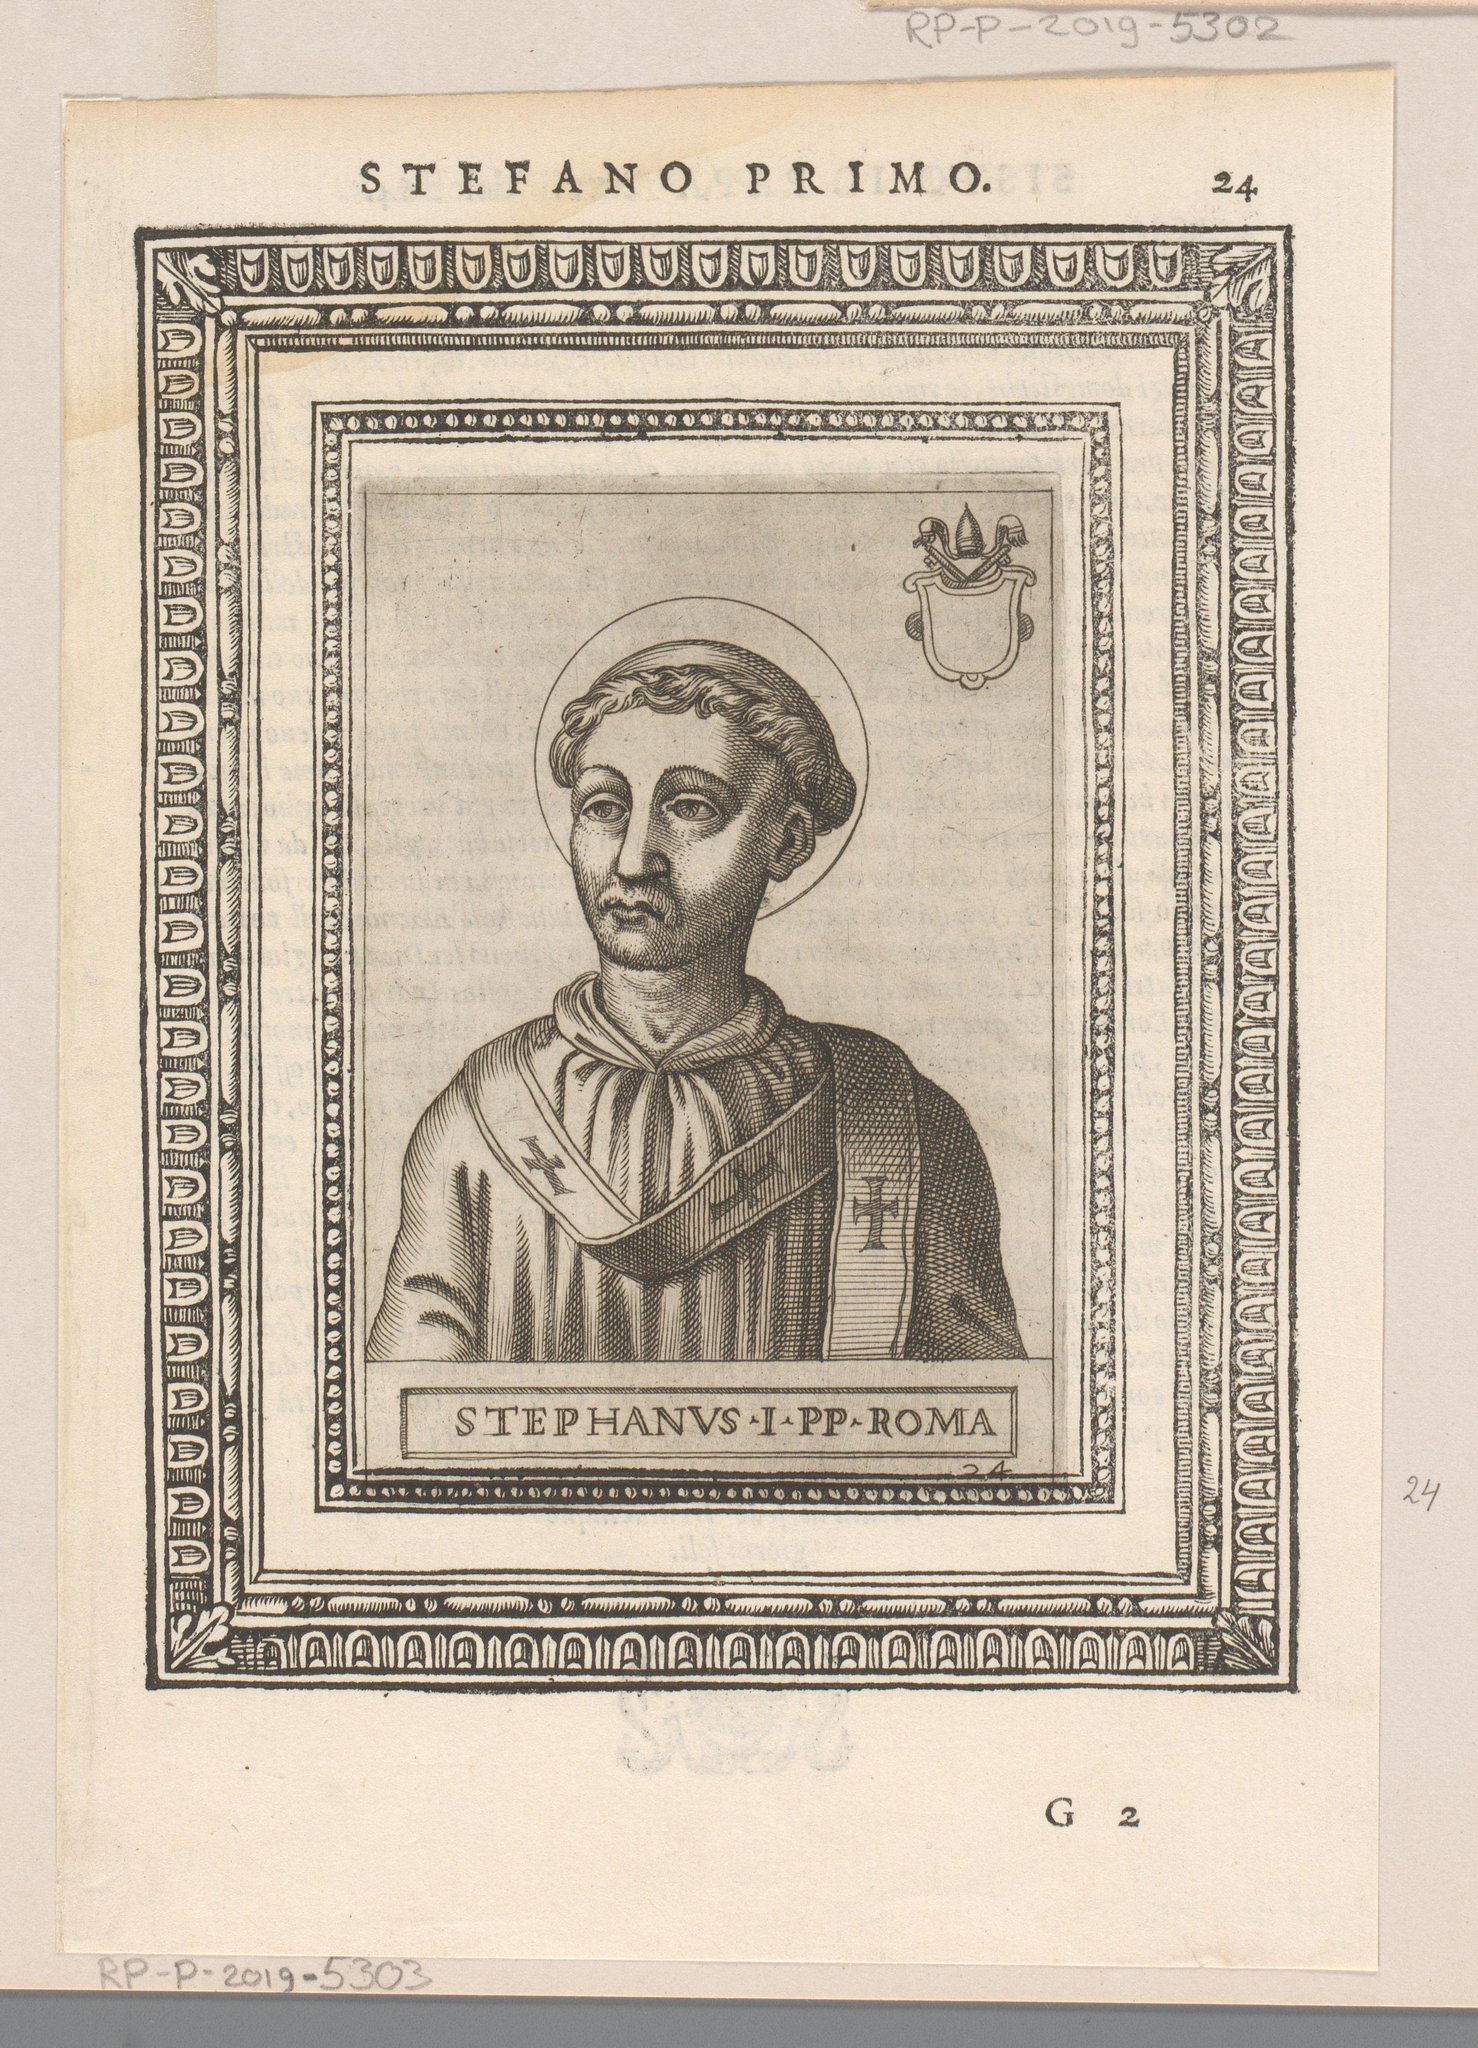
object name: print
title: Stephanus I PP Roma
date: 1587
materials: paper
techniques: engraving, letterpress printing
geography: rome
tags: historical persons, pope, armorial bearing, heraldry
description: Prent uit: Ciccarelli, Antonio. Le vite de Pontefici di Antonio Ciccarelli (...). Rome: Domenico Basa, 1587. Prent voor het eerst verschenen in: Cavalieri, Giovanni Battista de'. Pontificum romanorum effigies (...). Rome: Domenico Basa en Francesco Zanetti, 1580. Prent ook gebruikt in latere publicaties.